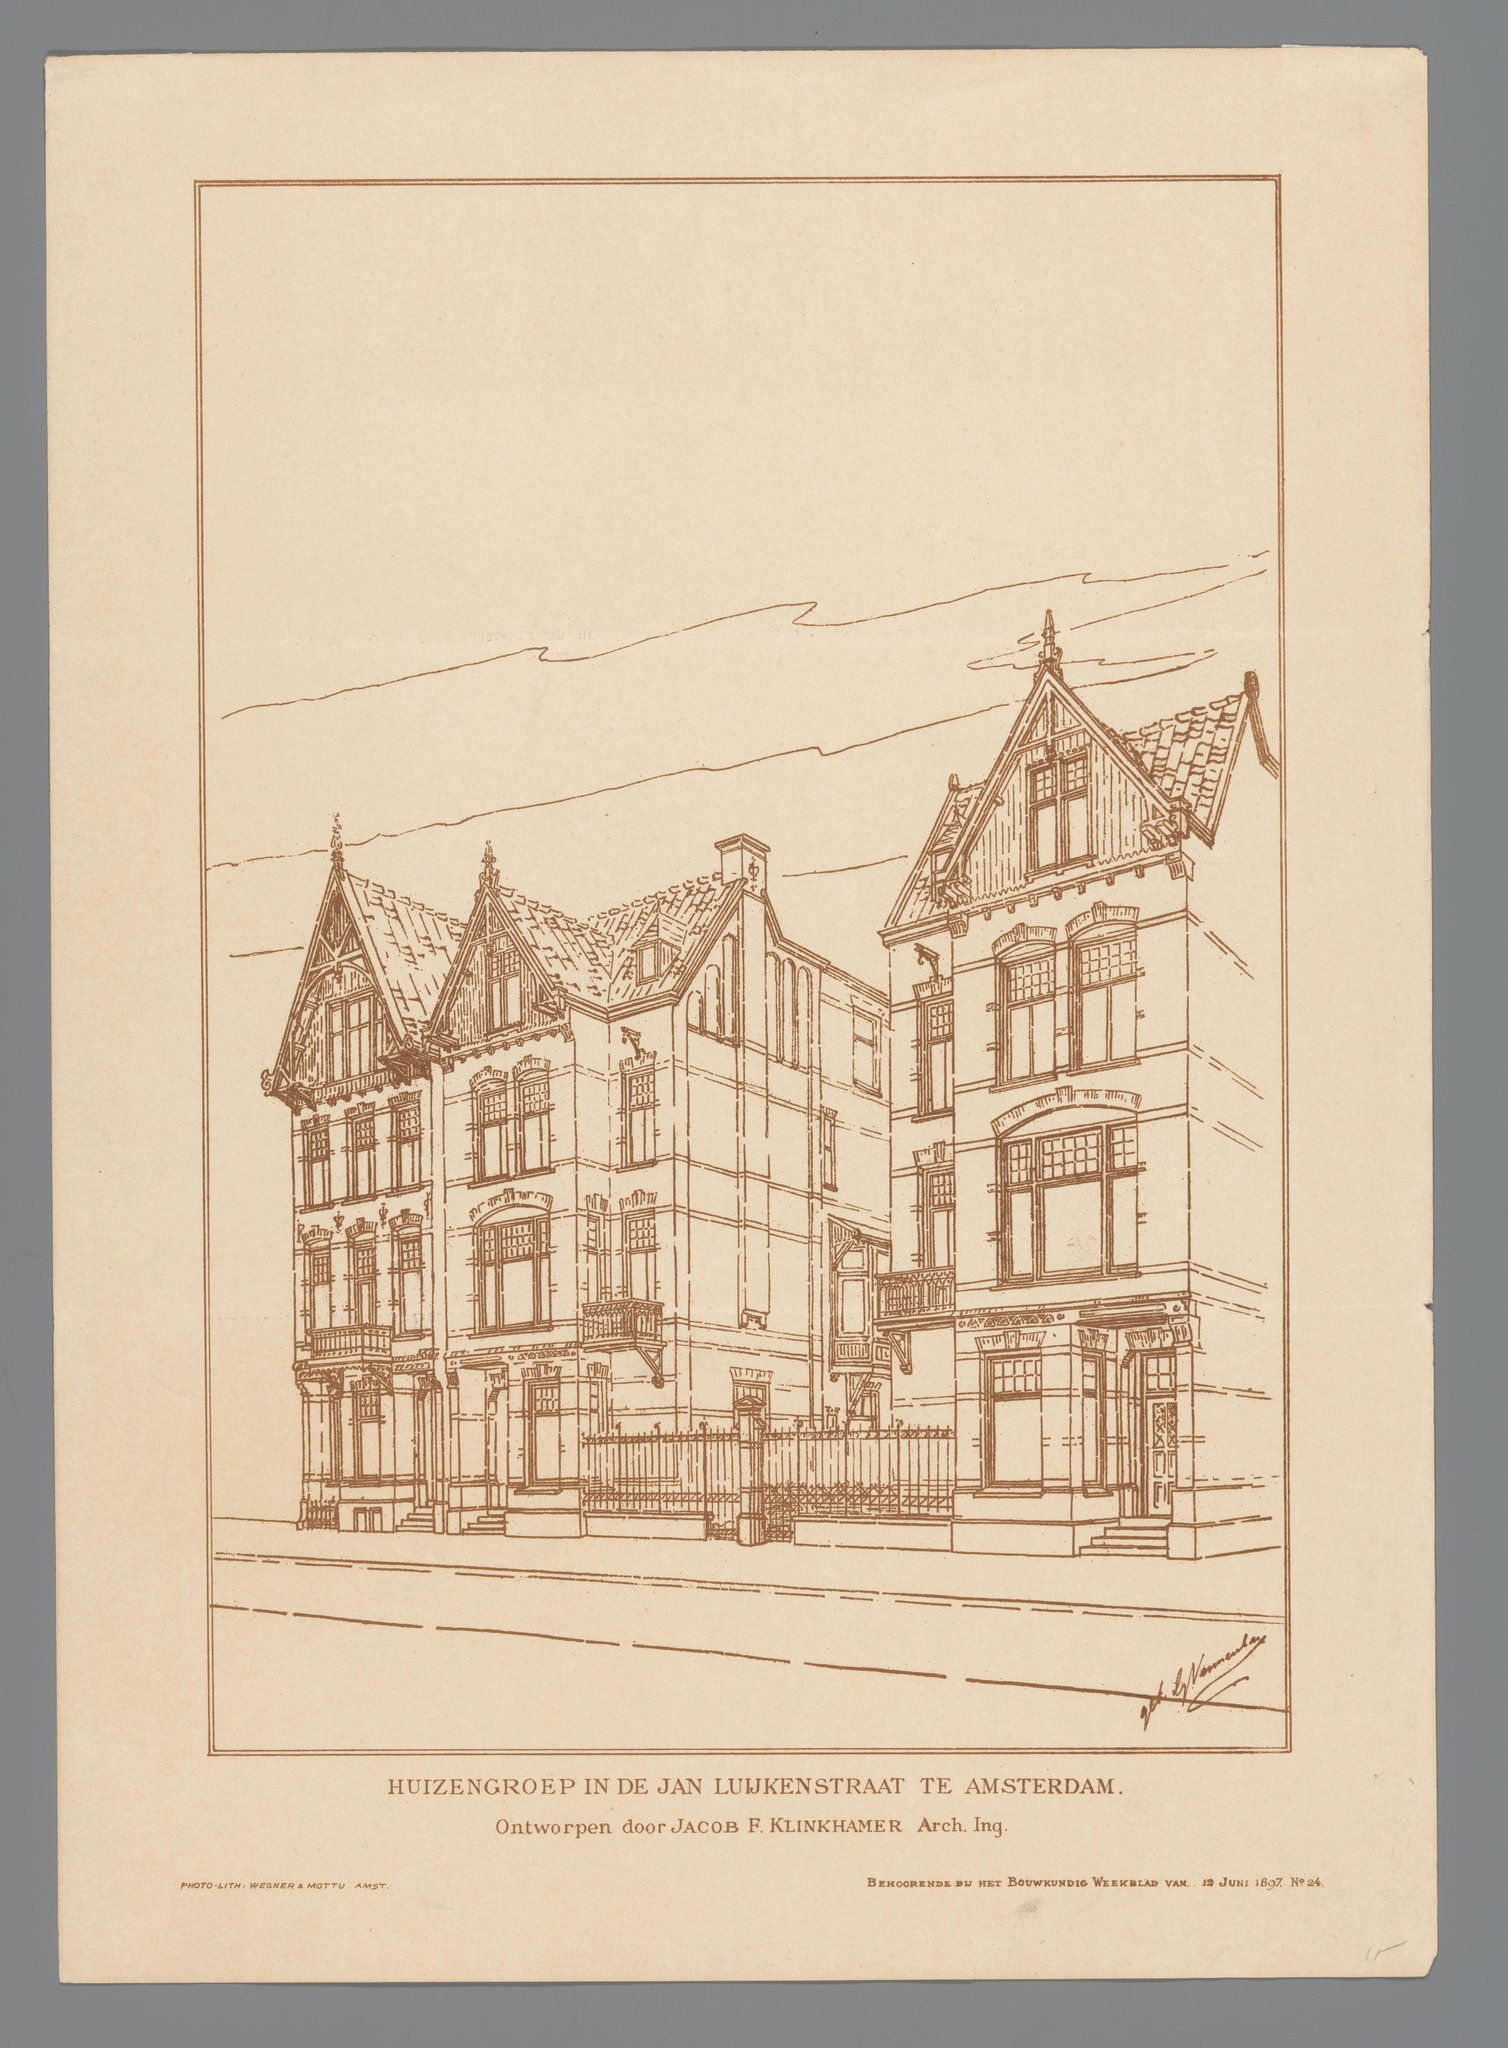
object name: print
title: Huizengroep in de Jan Luijkenstraat te Amsterdam. Ontworpen door Jacob F. Klinkhamer arch. ing.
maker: g. vermeulen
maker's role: schrijver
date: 1897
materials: paper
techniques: lithograph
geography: amsterdam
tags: village street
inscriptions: date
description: Prent uit: Bouwkundig weekblad 17 (1897), 12 juni 1897, nr. 24.